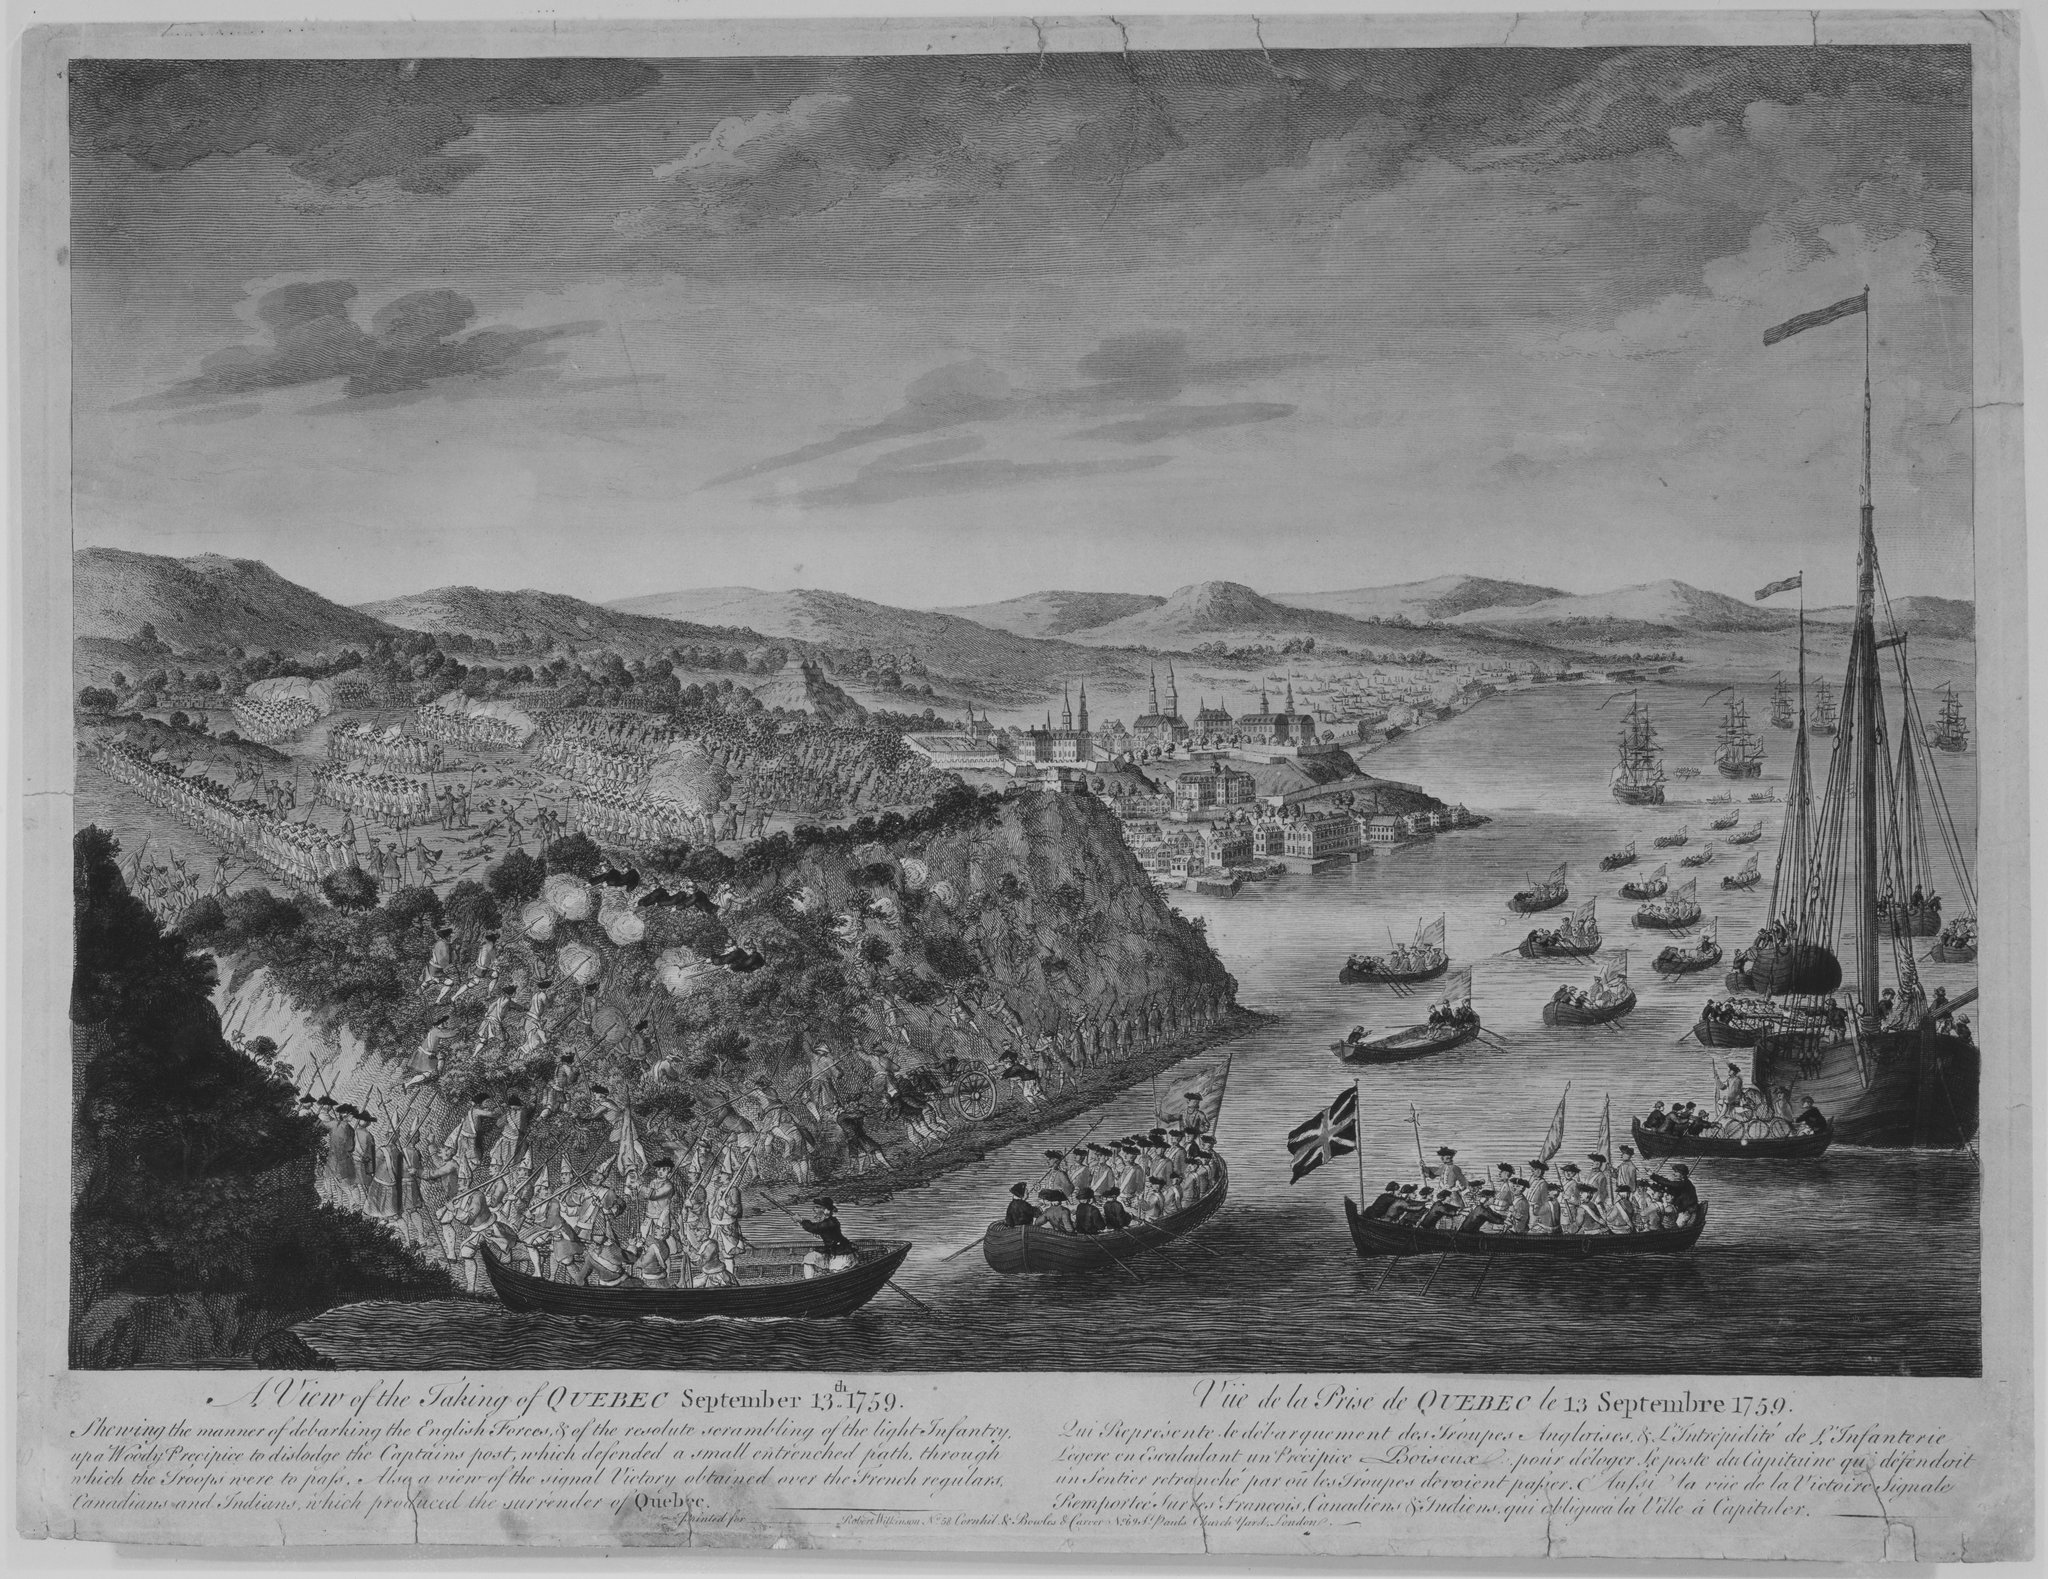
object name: print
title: A View of the Taking of Quebec, September 13, 1759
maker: bowles & carver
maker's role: publisher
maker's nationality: british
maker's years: 1793-1832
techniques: engraving, hand coloring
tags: men,hills,flags,boats,ships